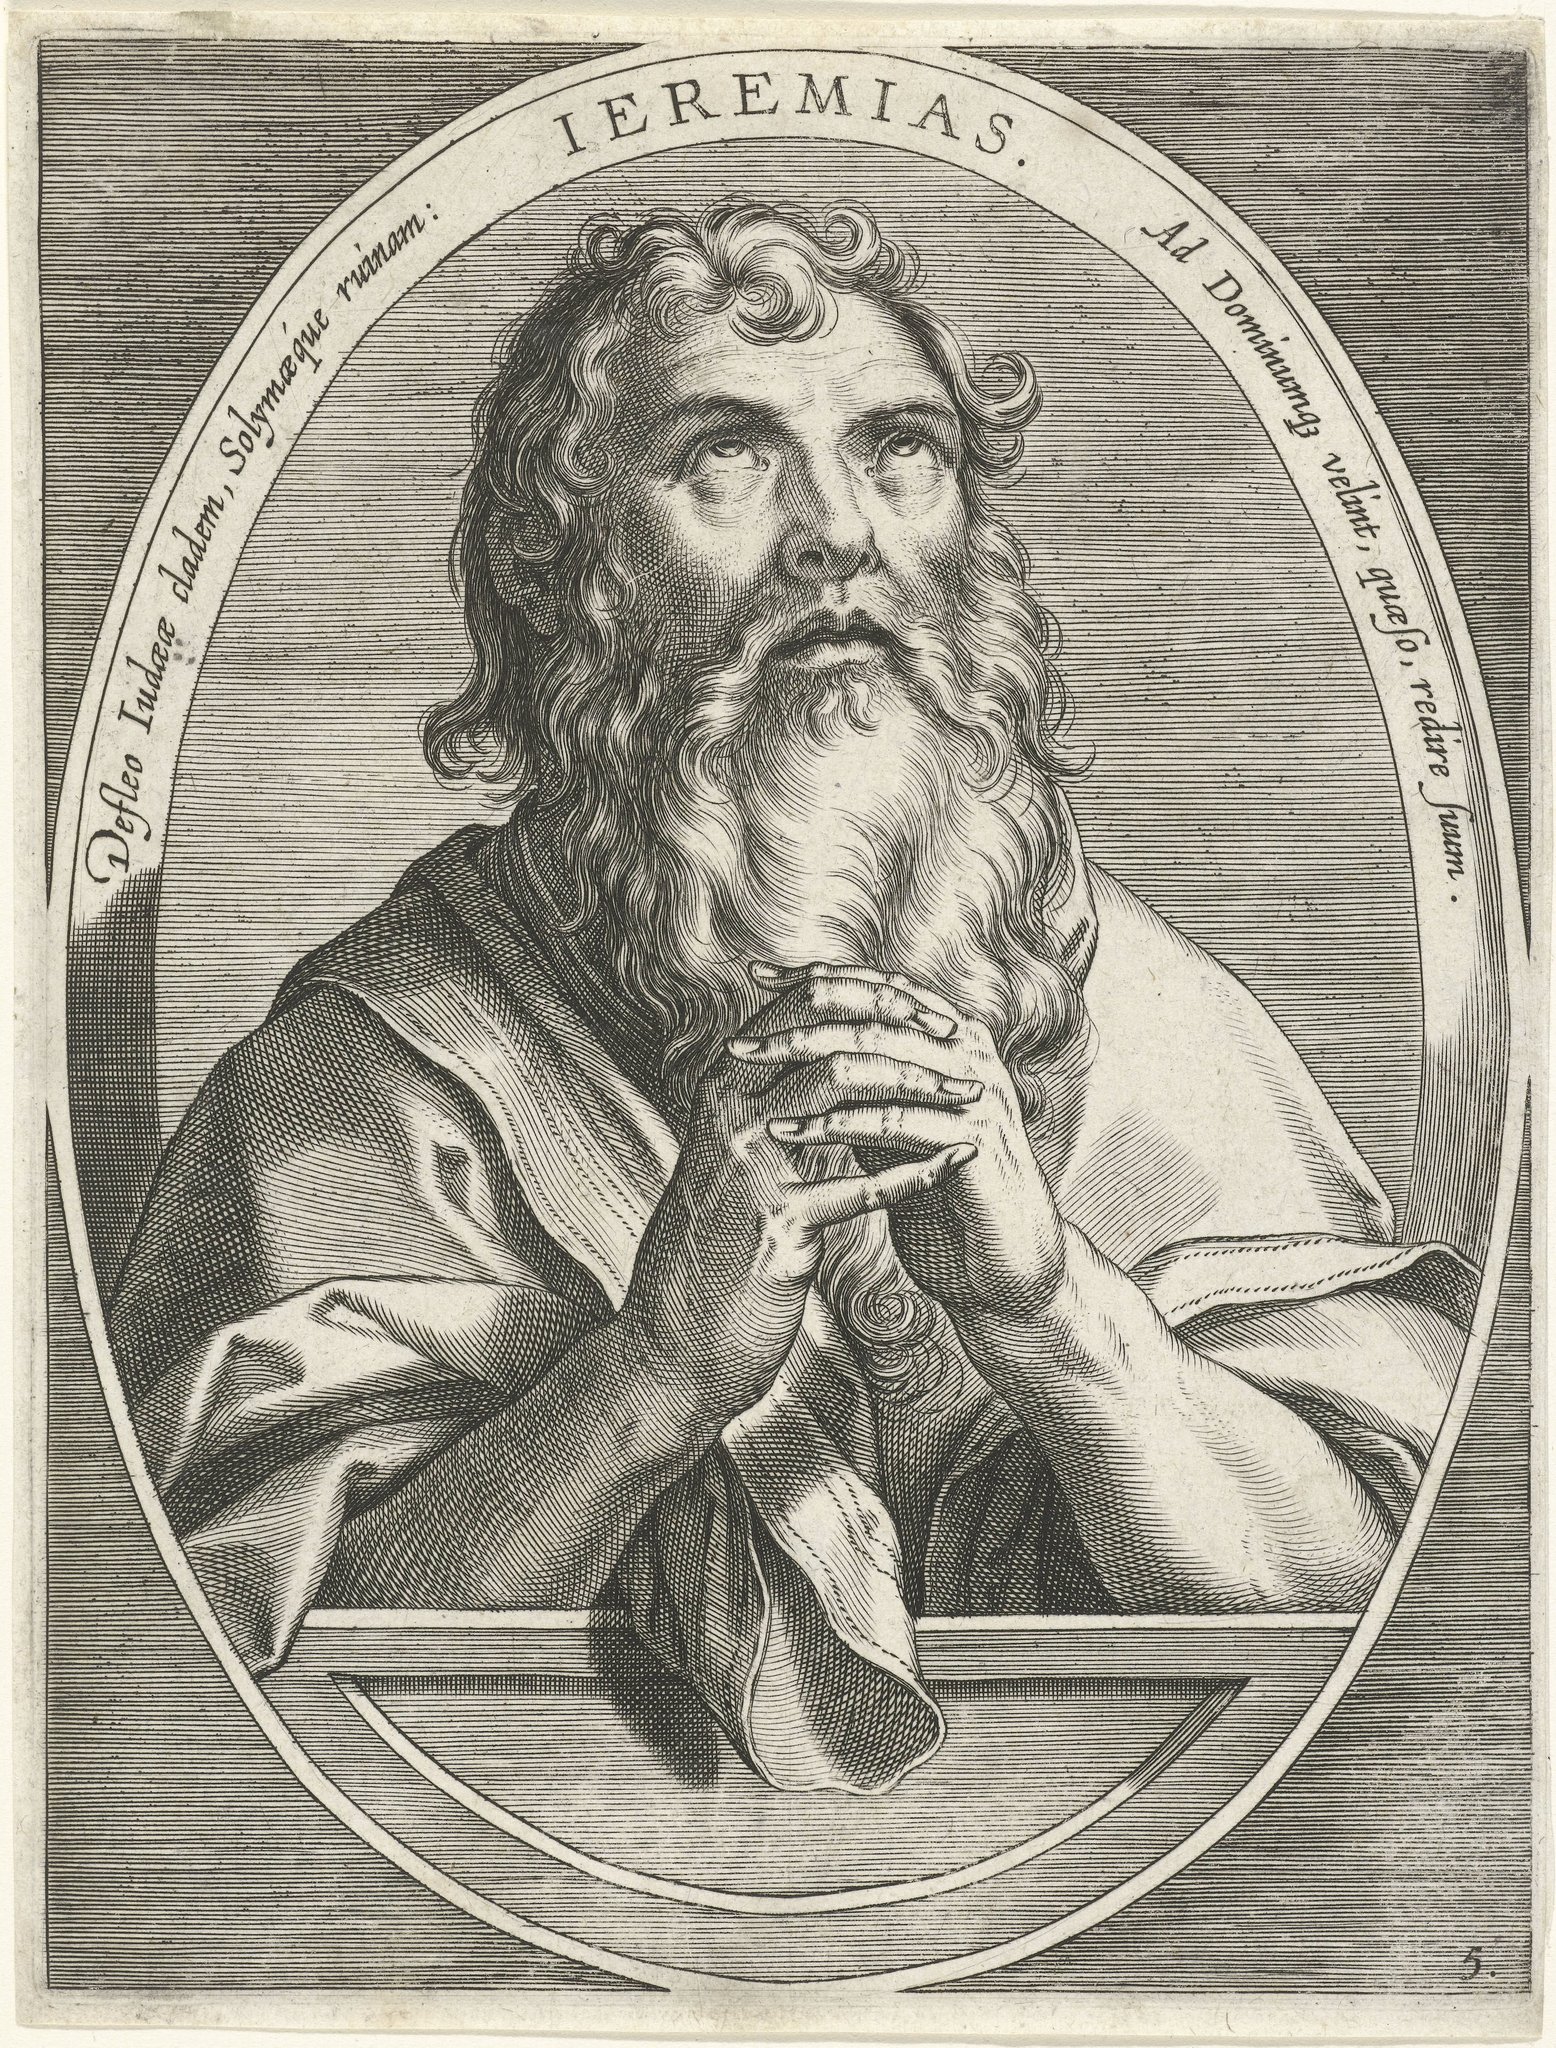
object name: print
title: Jeremia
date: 1613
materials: paper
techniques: engraving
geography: antwerp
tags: jeremiah (not in biblical context); possible attributes: book or scroll, 'the seething pot'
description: De profeet Jeremia in ovaal met Latijns randschrift. Hij heeft zijn handen gevouwen om te bidden, zijn blik is naar boven gericht.